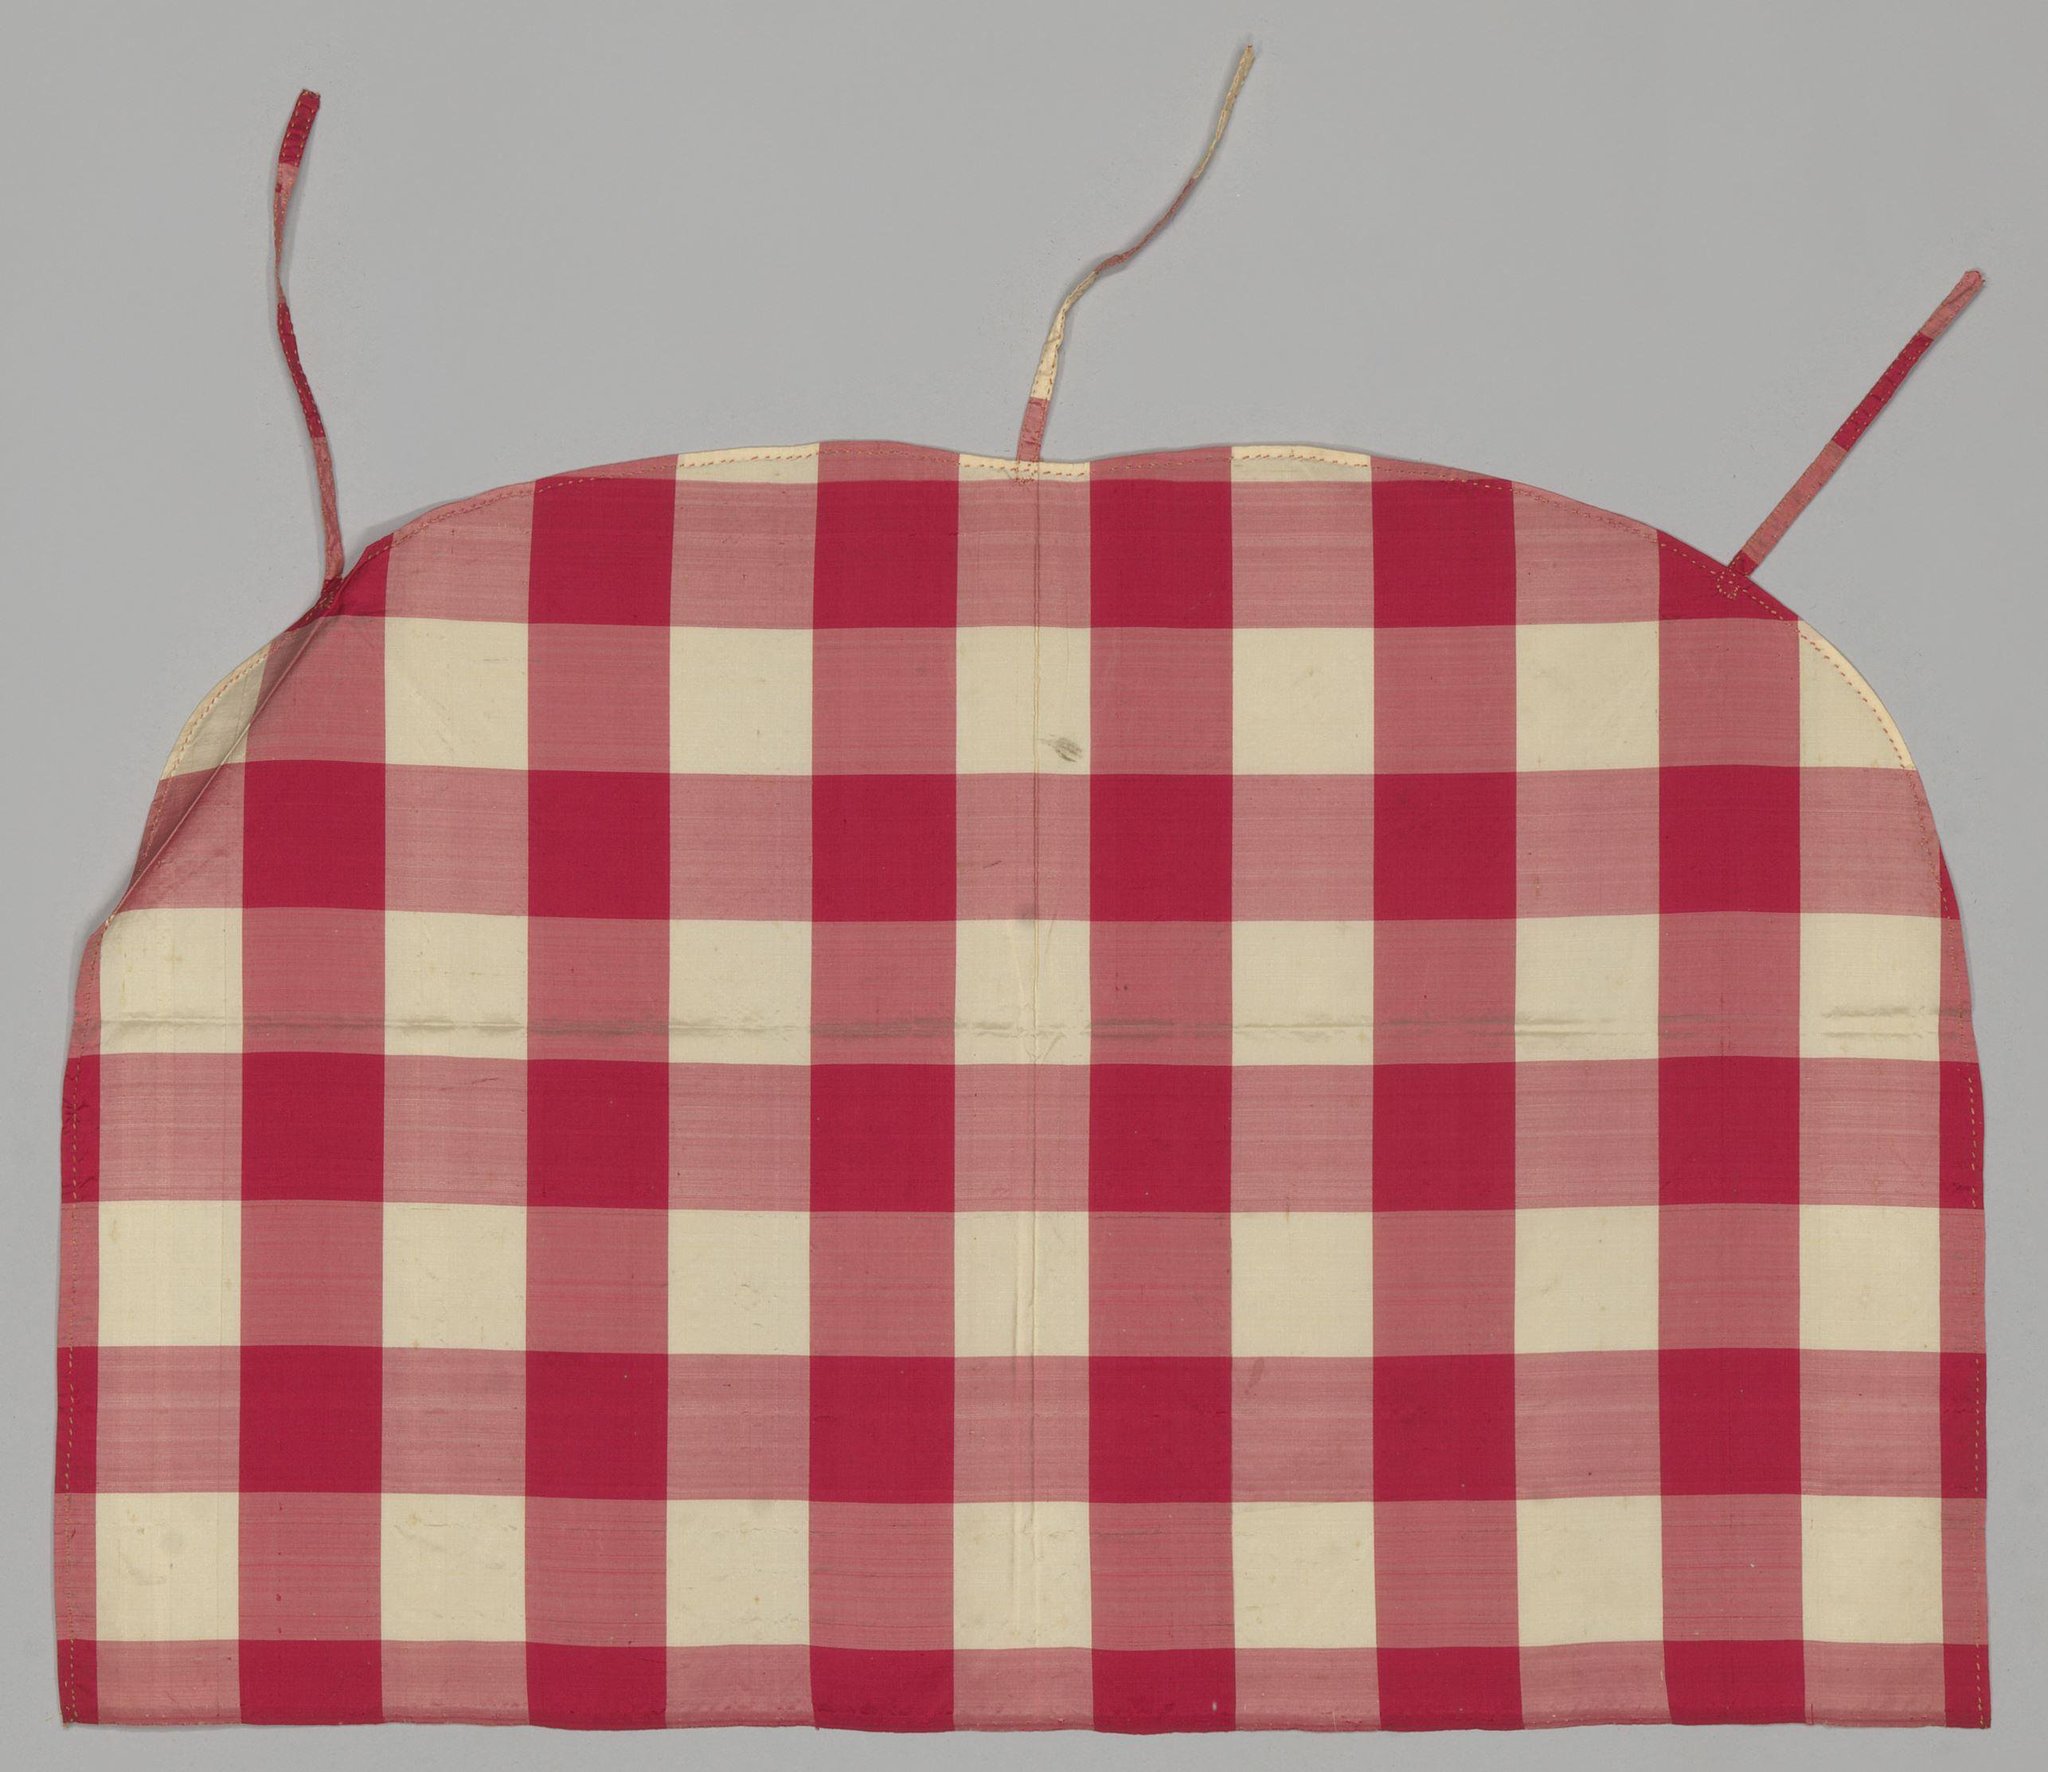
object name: gordijngarnituur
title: Gordijngarnituur, mogelijk een gordijnval, van rood-wit geblokte zijde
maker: Anonymous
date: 1776-1800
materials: silk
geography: northern netherlands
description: Schildvormig gordijngarnituur, mogelijk een gordijnval, met drie bandjes van dezelfde stof van ca. 10.0 cm.